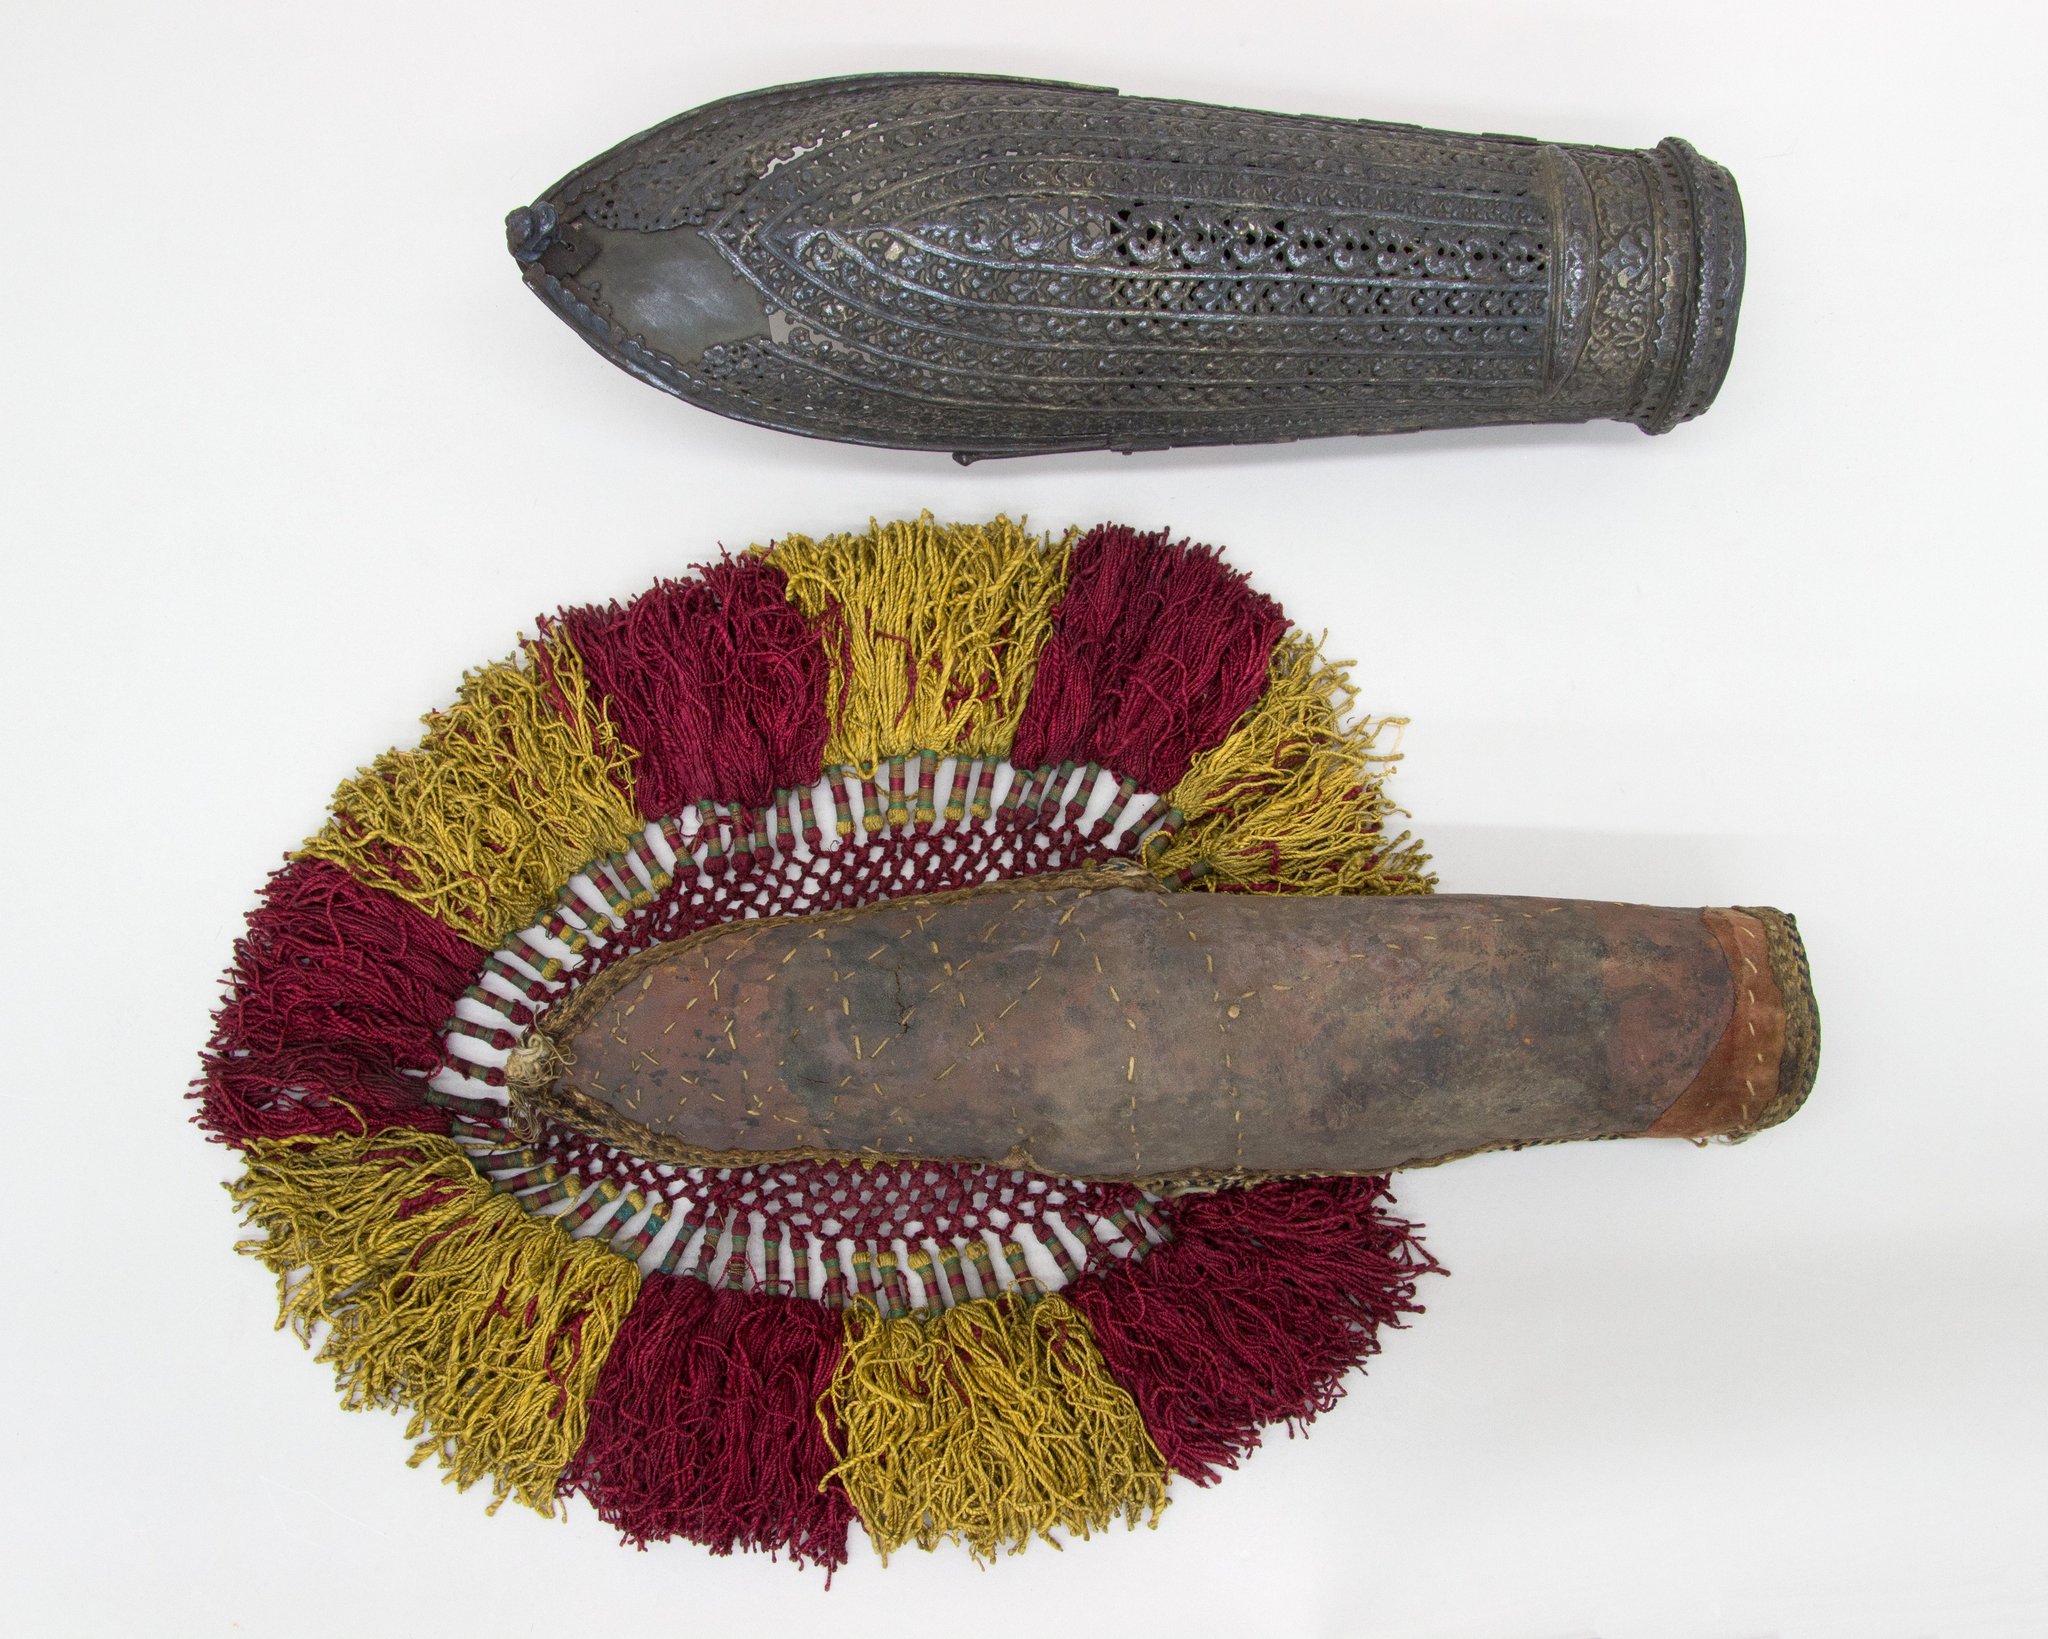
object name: arm guard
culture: indian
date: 1701-1800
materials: silver, steel, textile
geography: south india